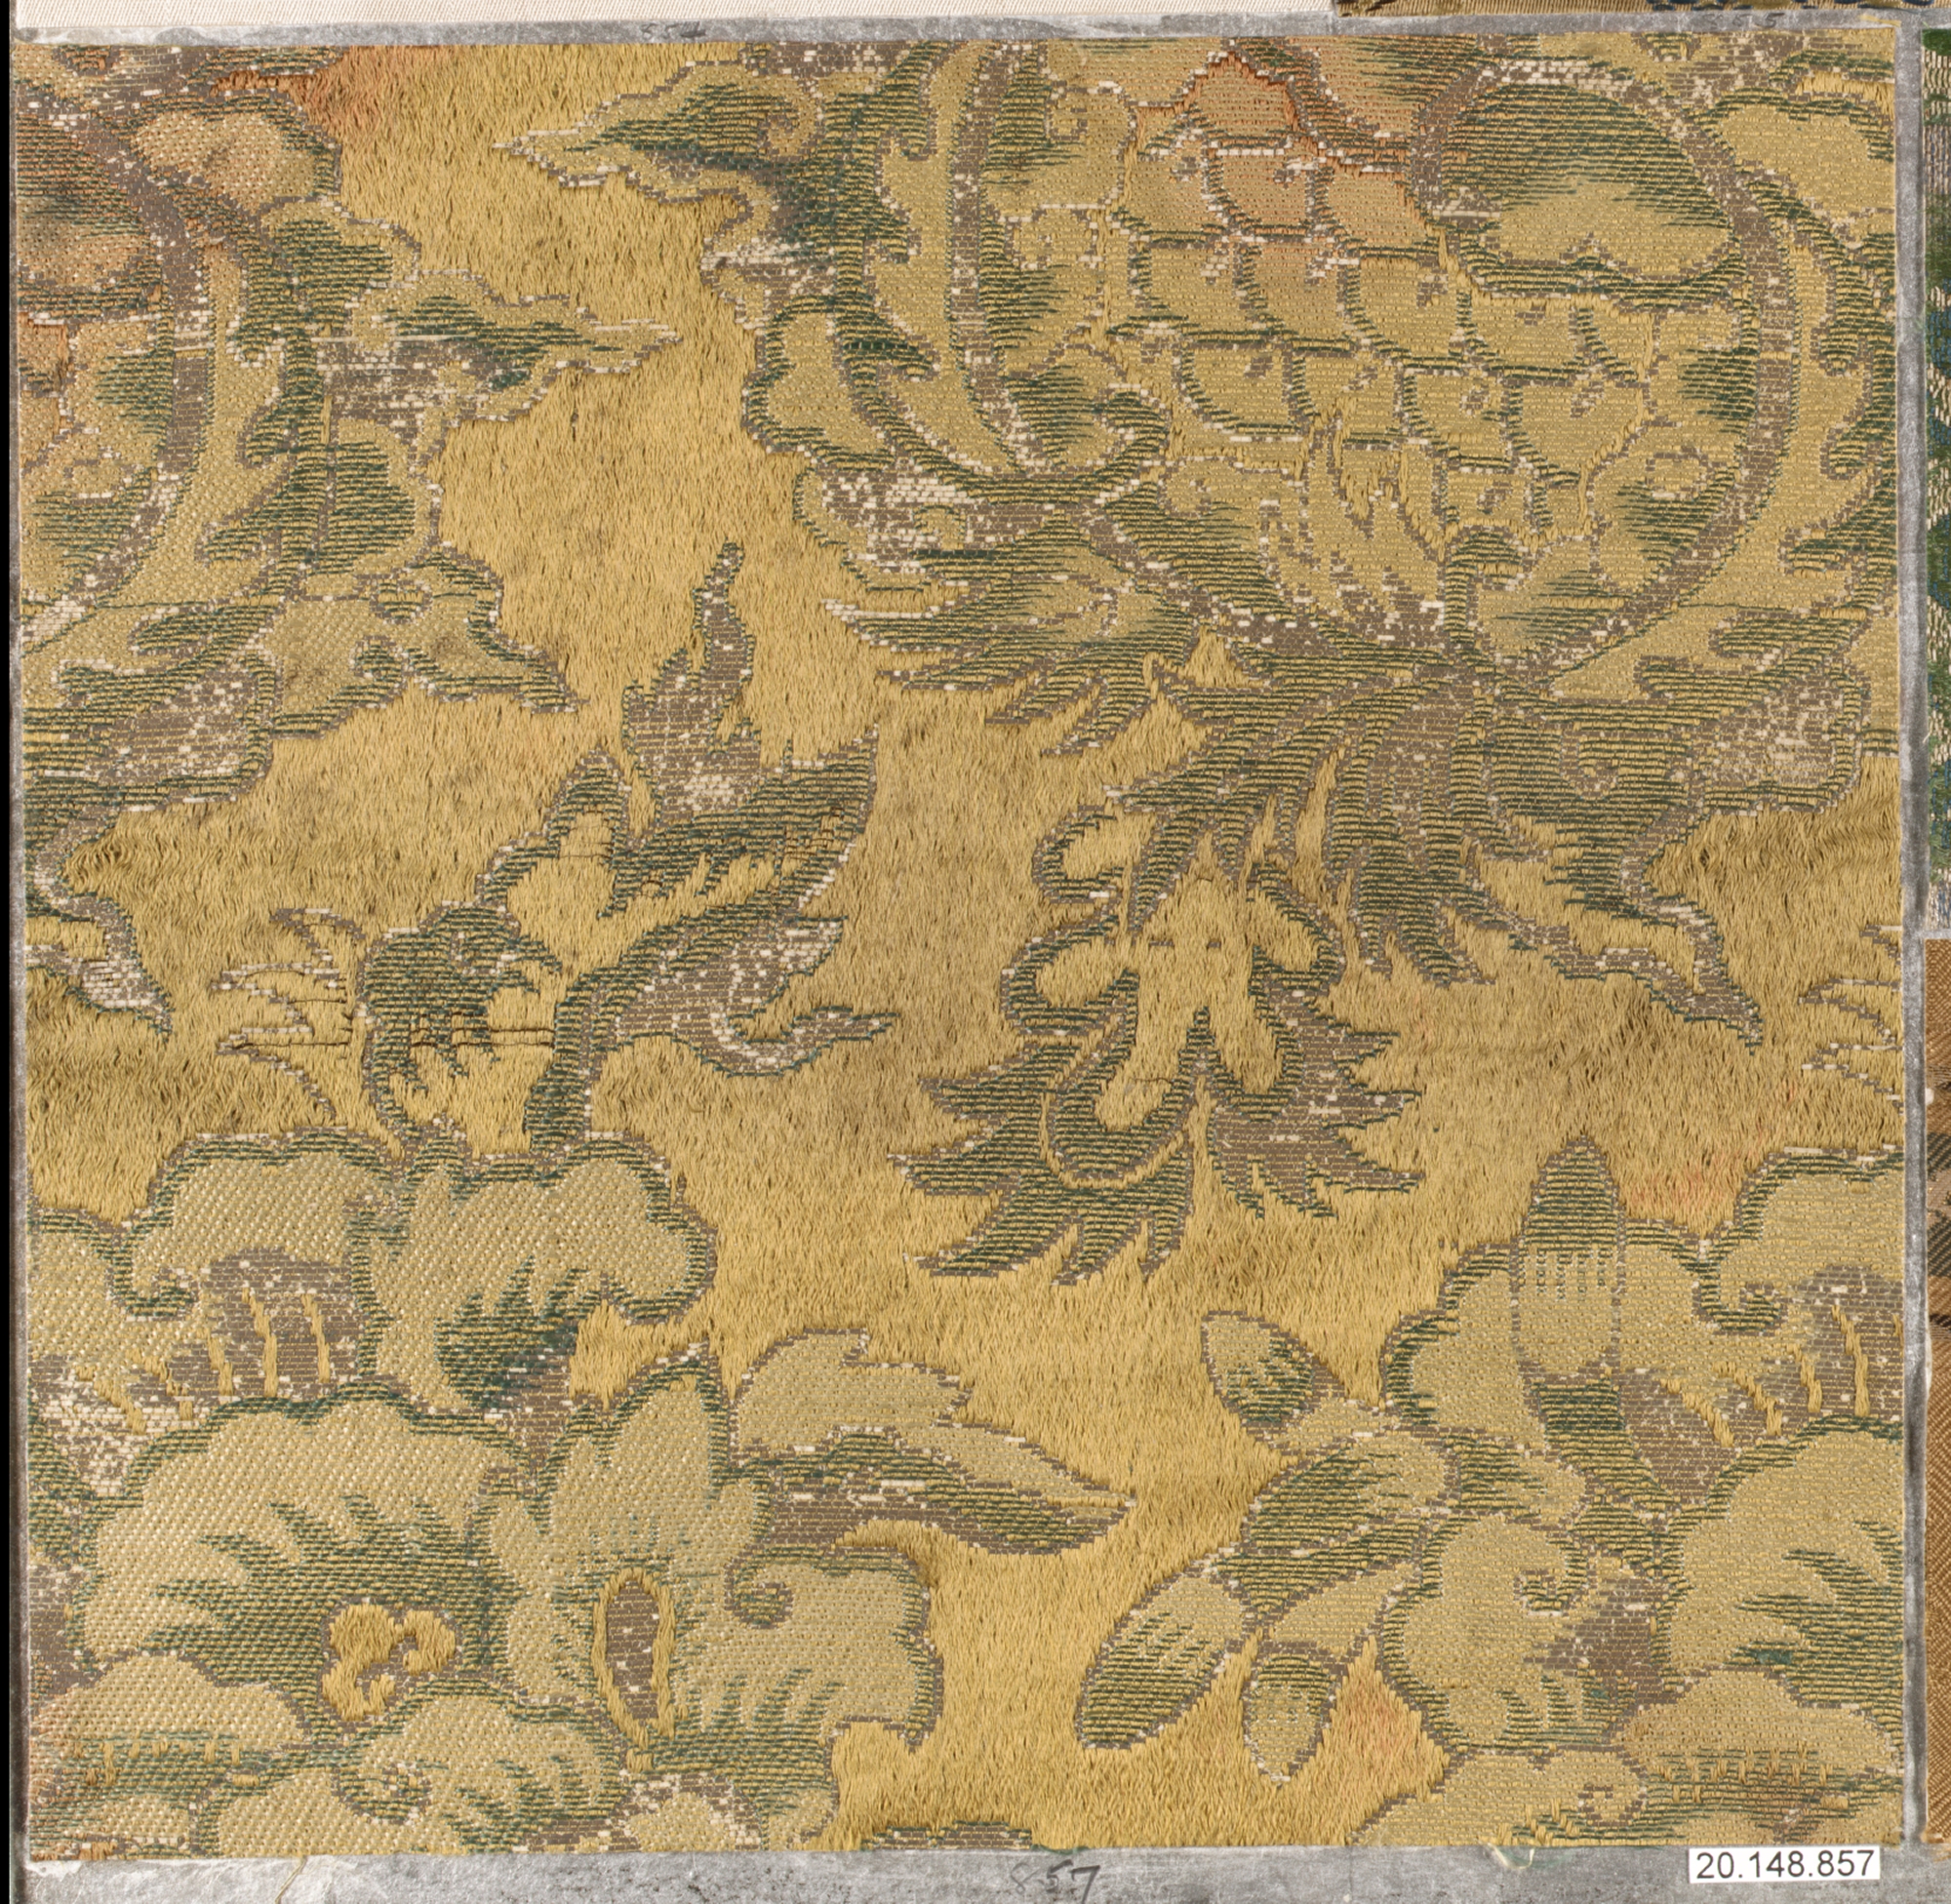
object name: piece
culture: japanese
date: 1701-1800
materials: silk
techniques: compound weave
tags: flowers